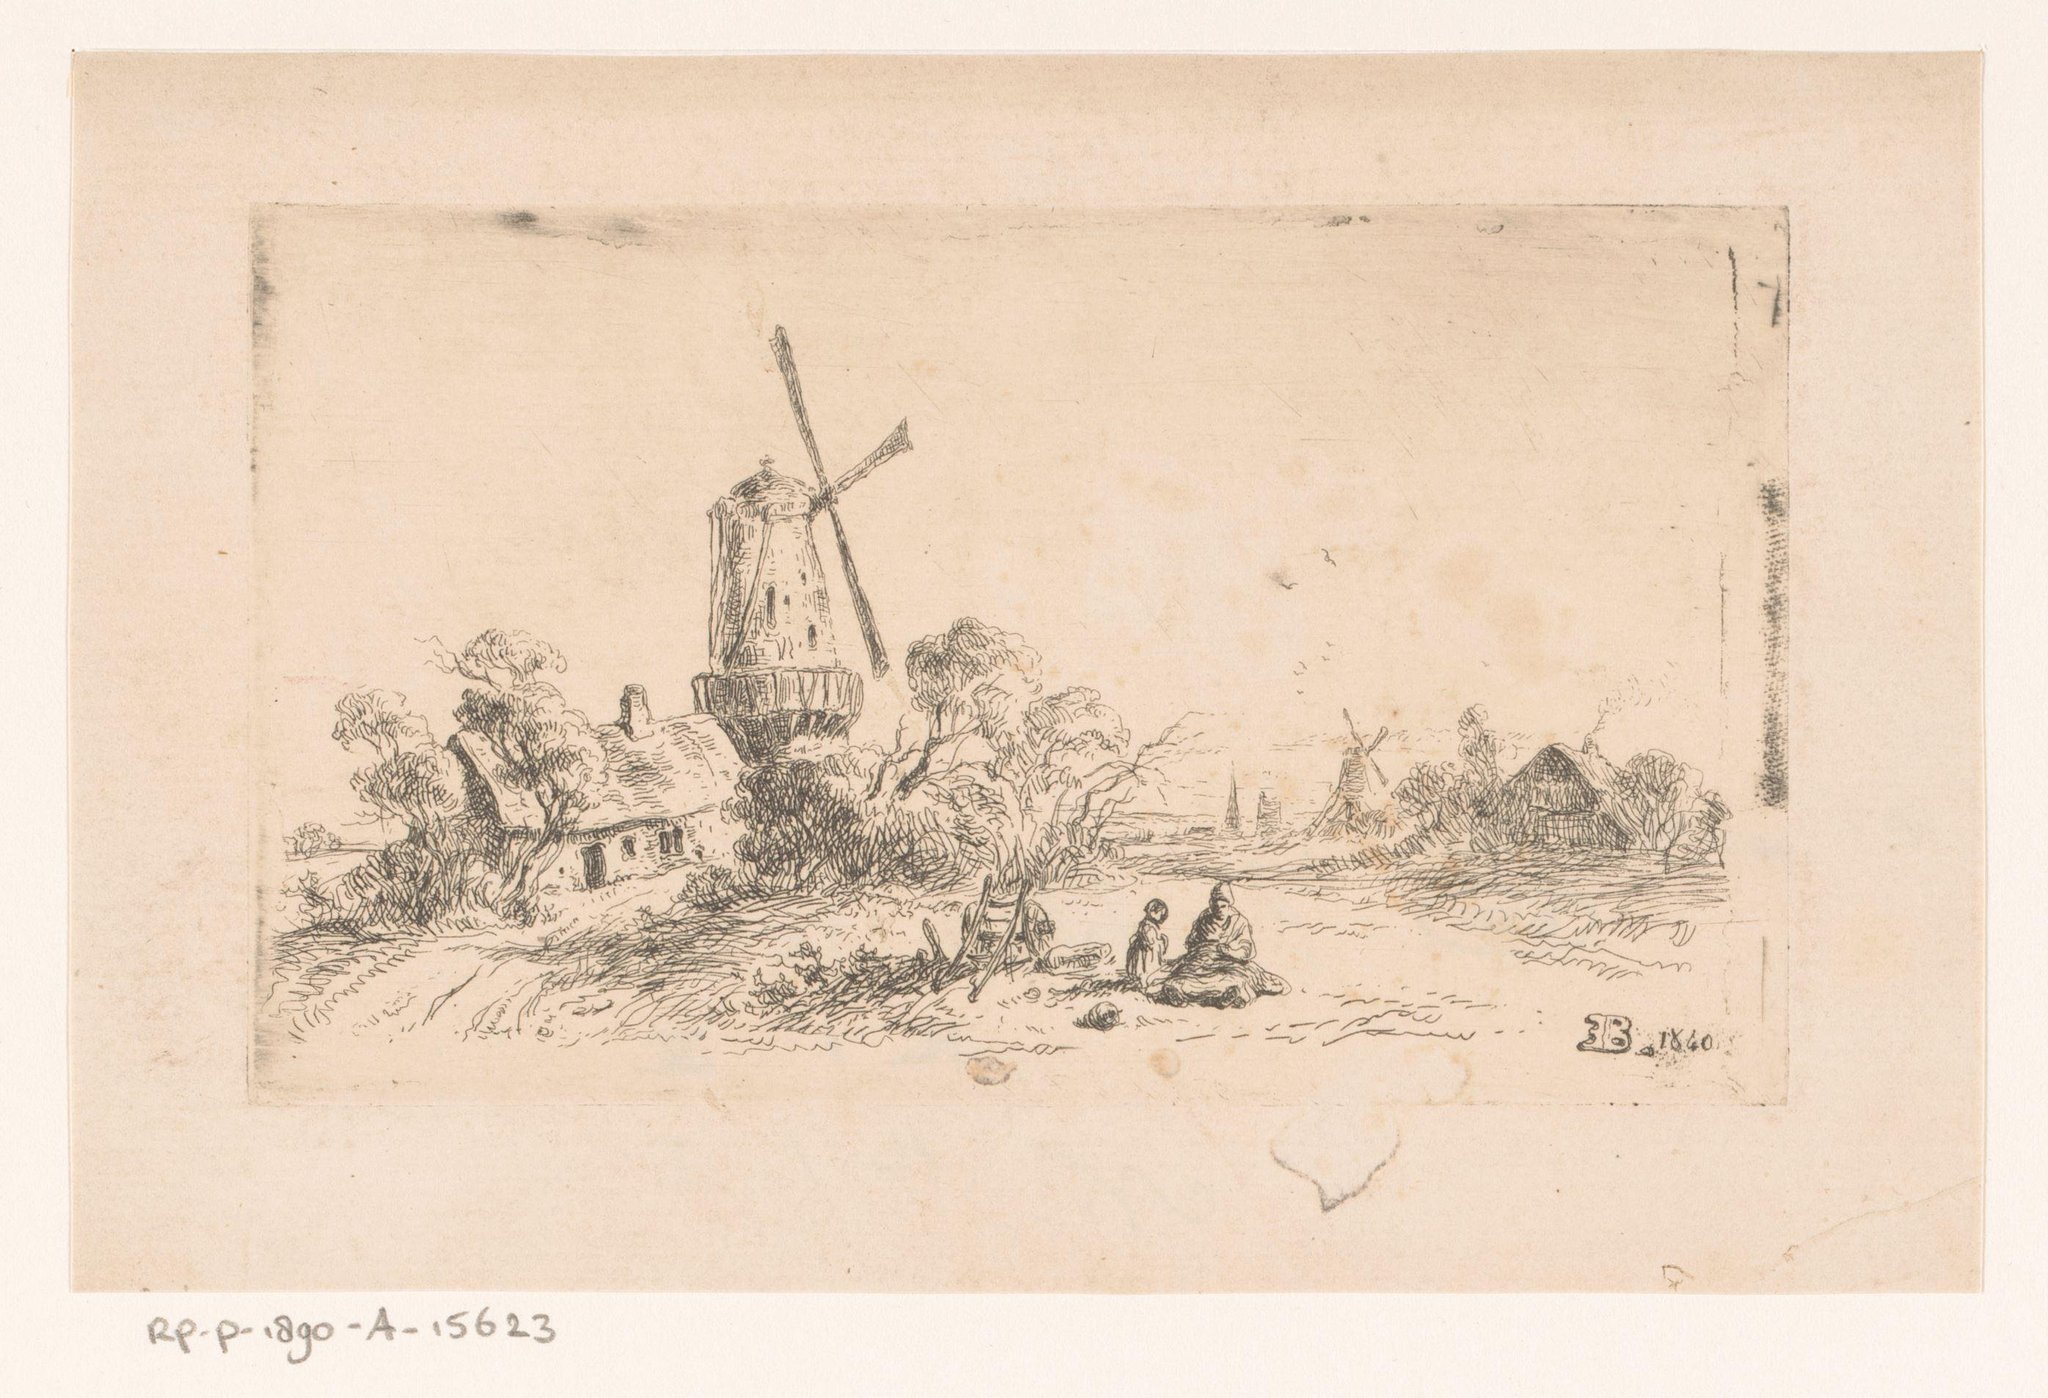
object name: print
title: Landschap met molen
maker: eugène françois de block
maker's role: draughtsman, painter, print maker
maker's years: 1812-1893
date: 1840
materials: paper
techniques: etching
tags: landscapes, windmill in landscape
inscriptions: collector's mark: Lugt 2228